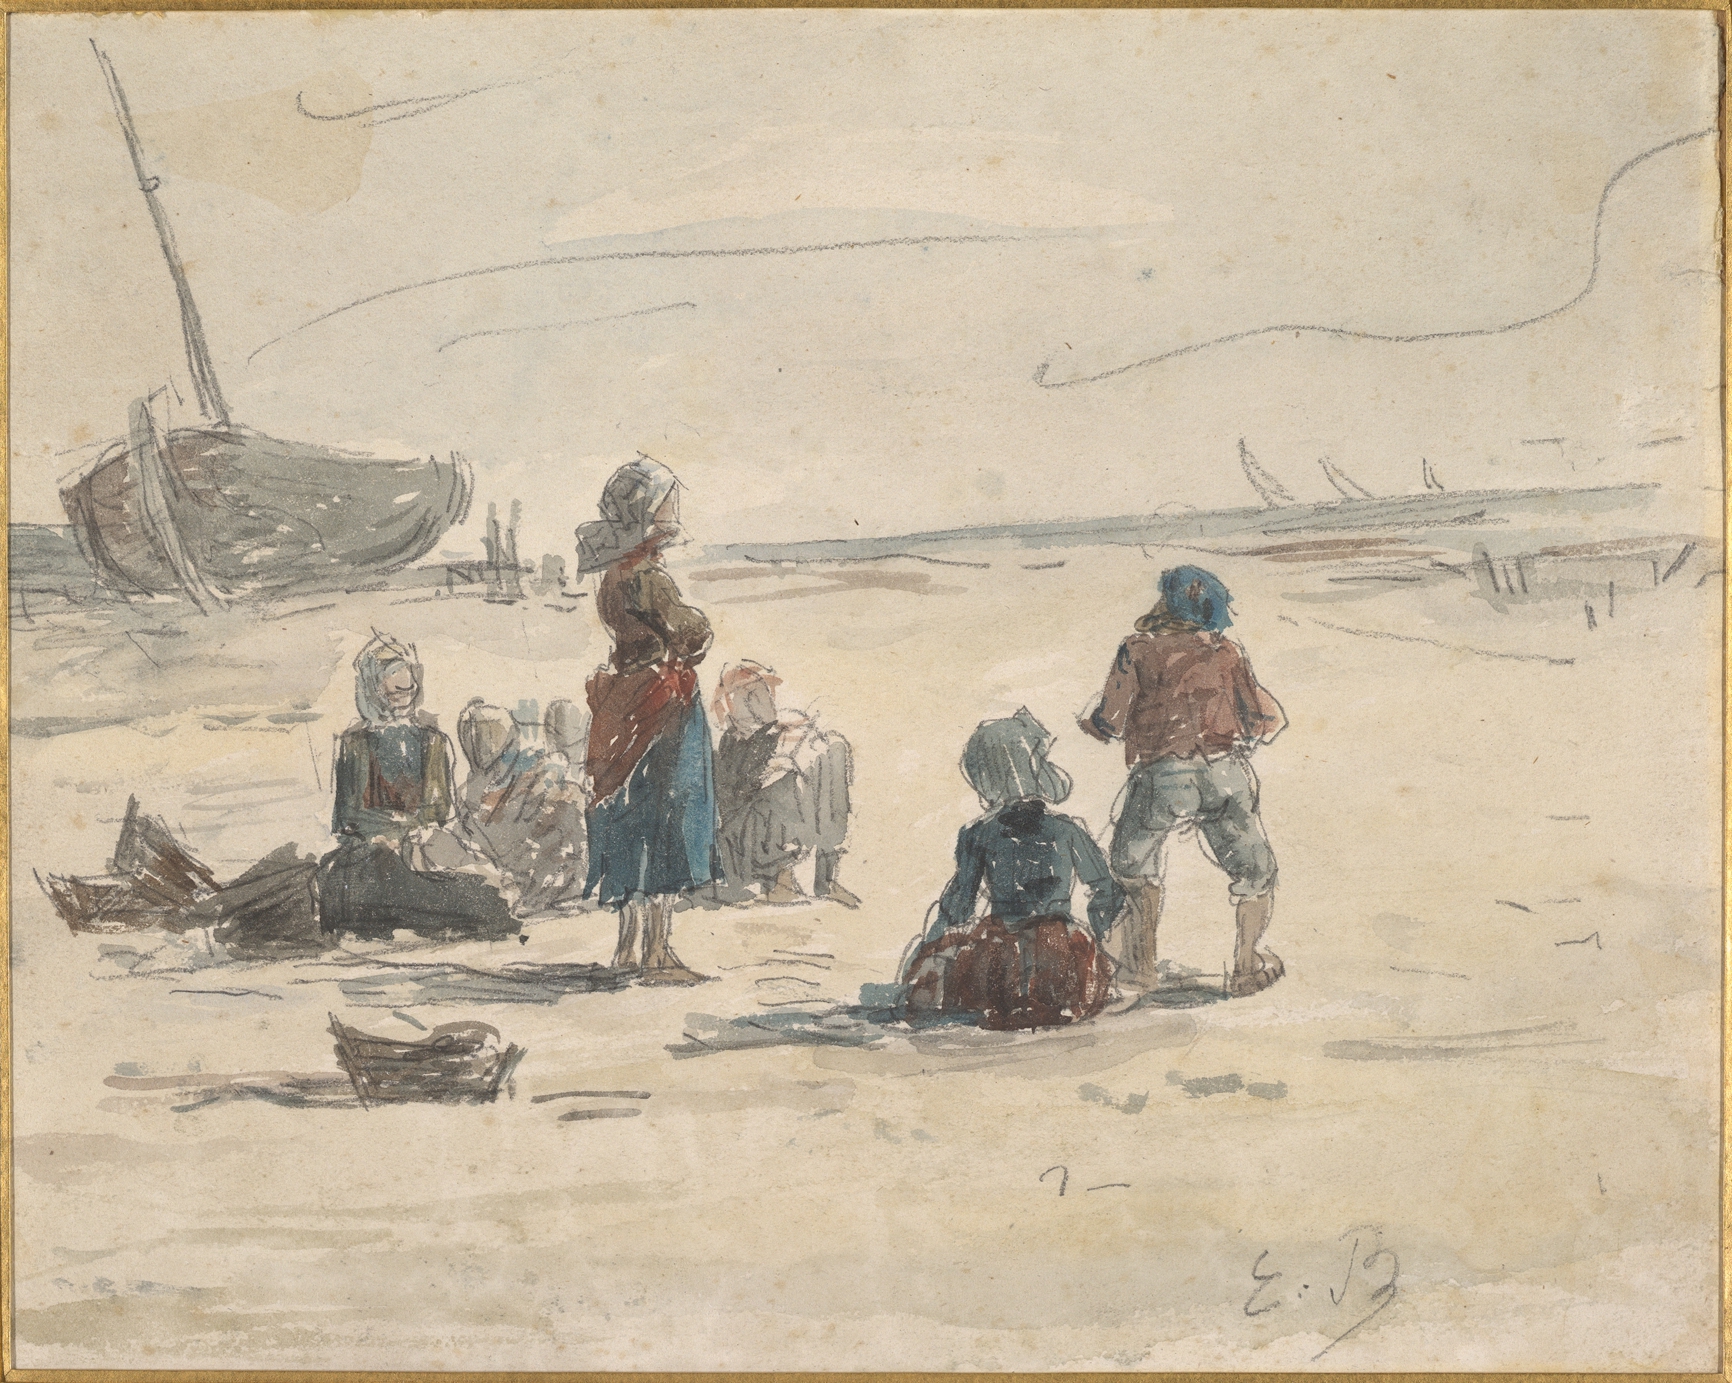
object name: drawing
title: Fishermen's Wives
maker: eugène boudin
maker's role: artist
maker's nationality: french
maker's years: 1824-1898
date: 1855-1860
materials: graphite, watercolor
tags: women,boats